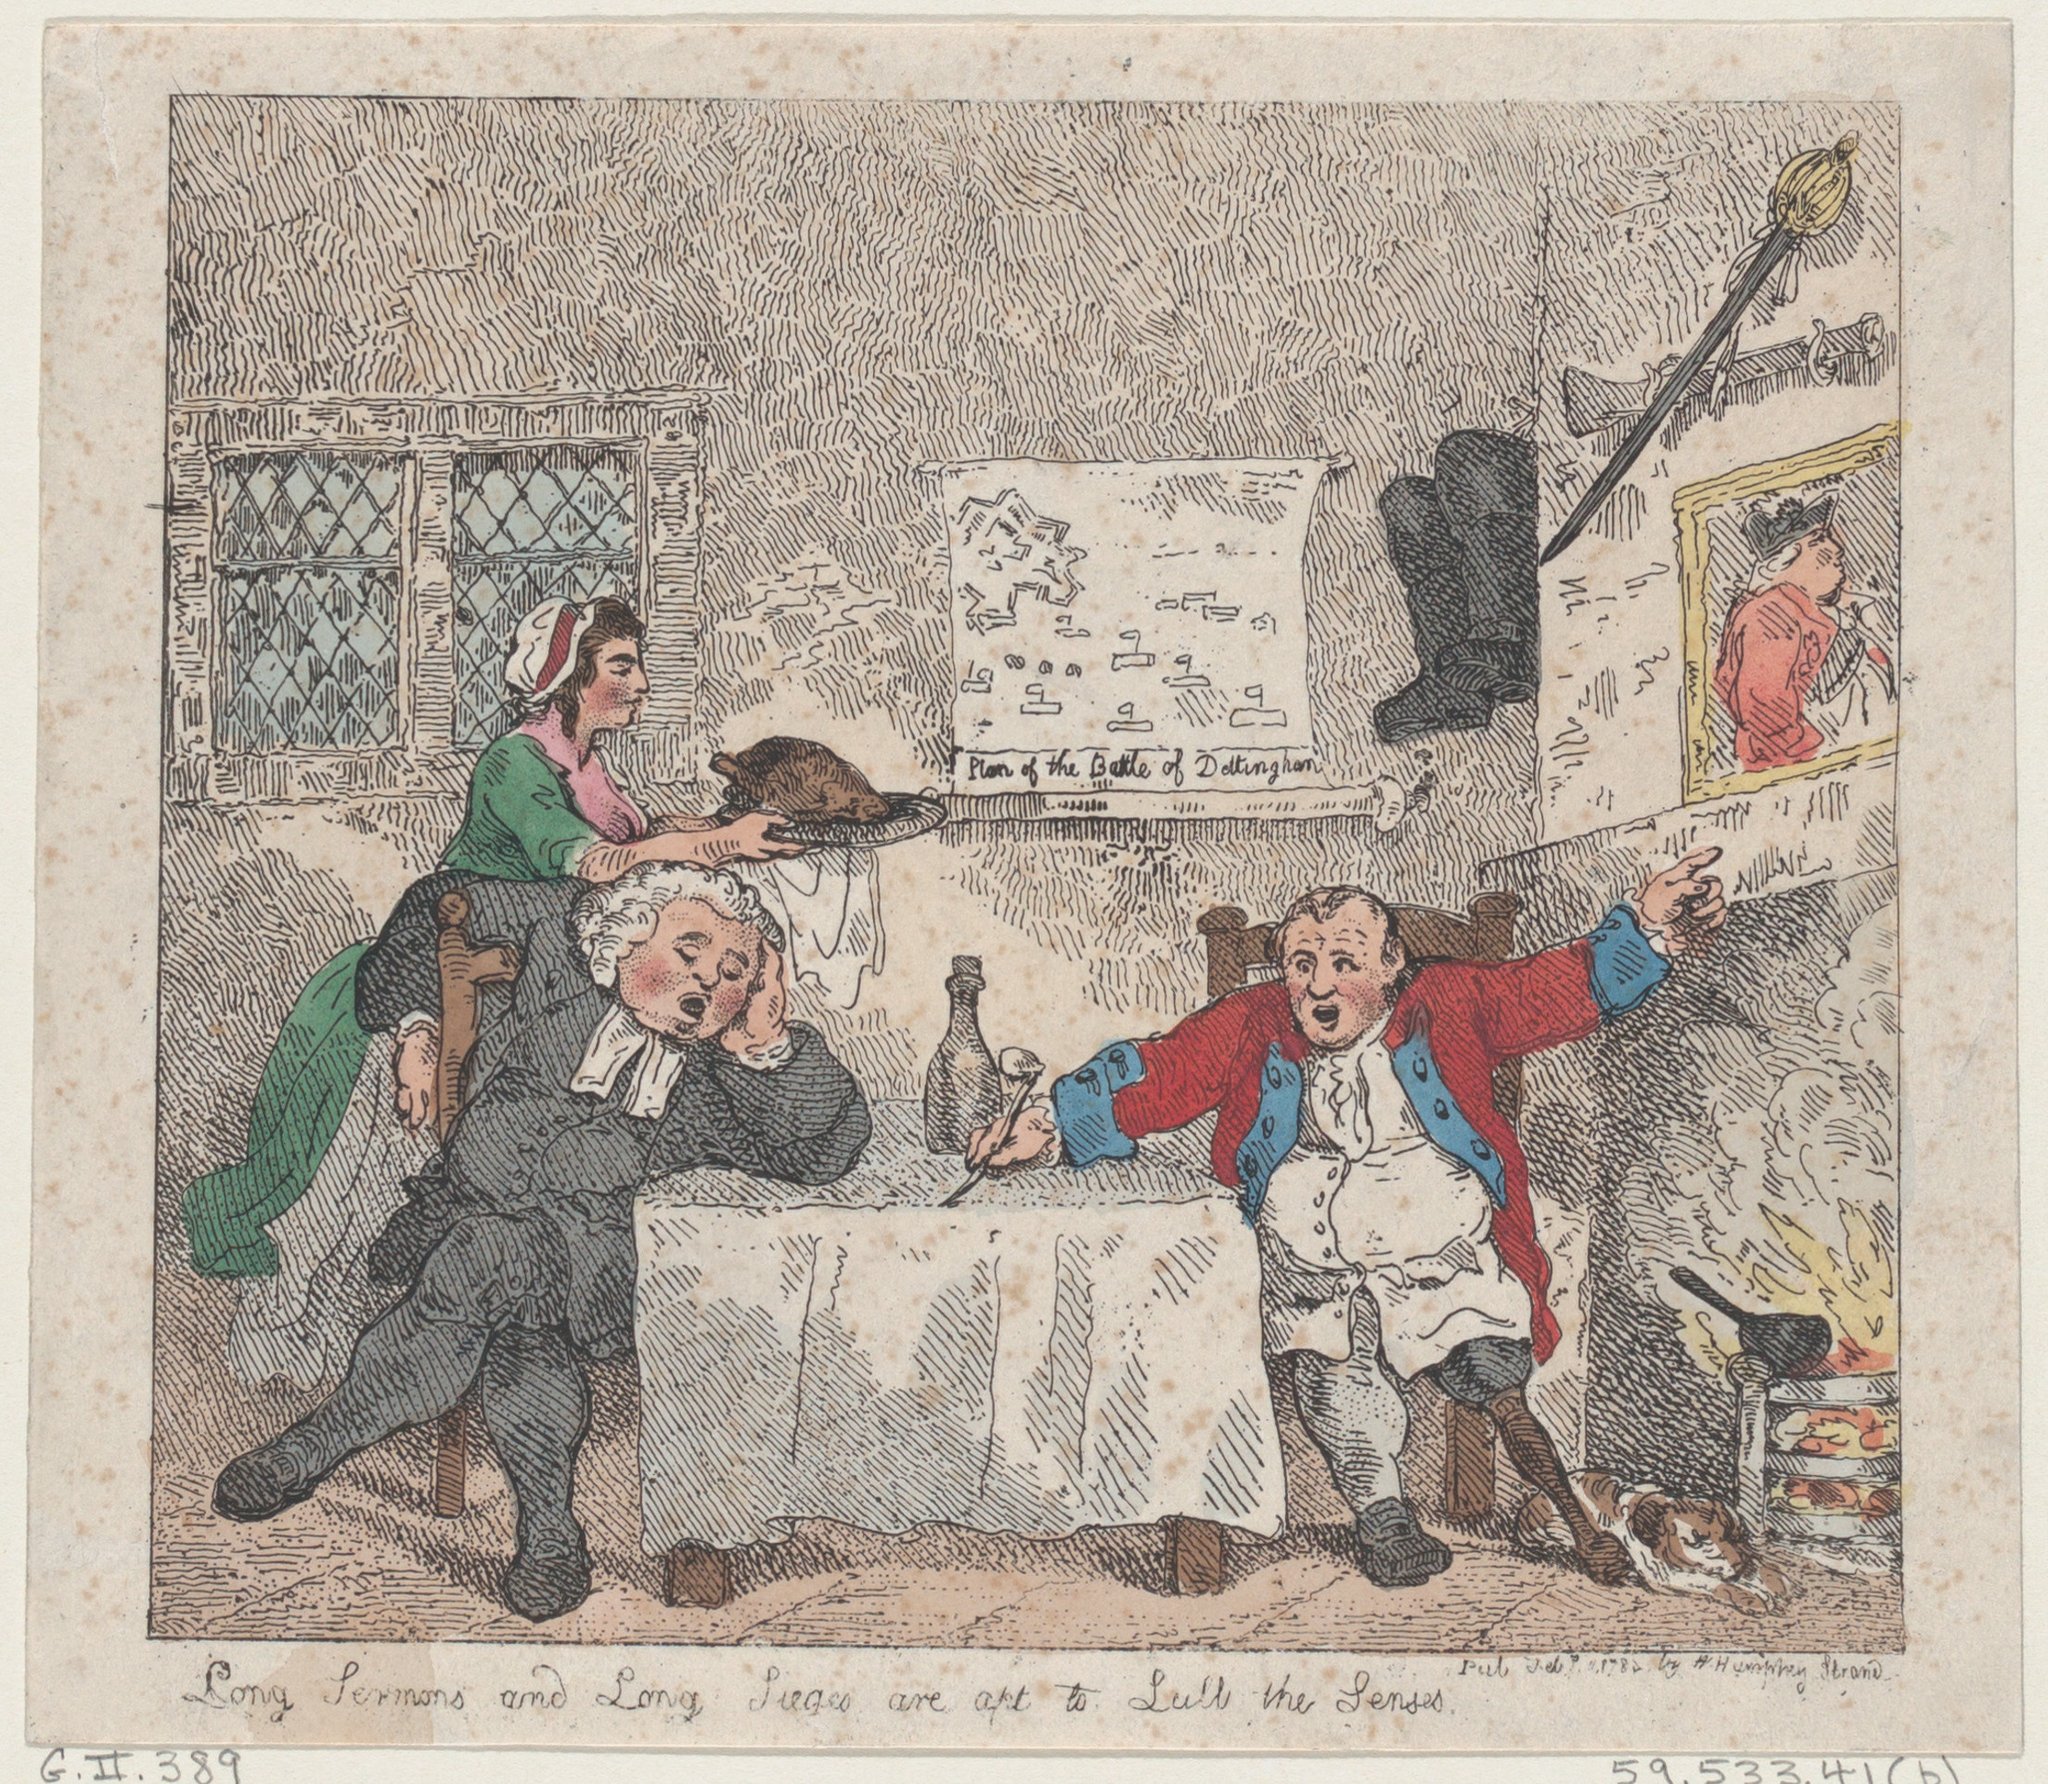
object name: print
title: Long Sermons and Long Sieges are apt to Lull the Senses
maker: thomas rowlandson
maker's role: artist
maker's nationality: british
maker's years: 1757-1827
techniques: aquatint, etching, hand coloring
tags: food,satire,sleeping,men,women